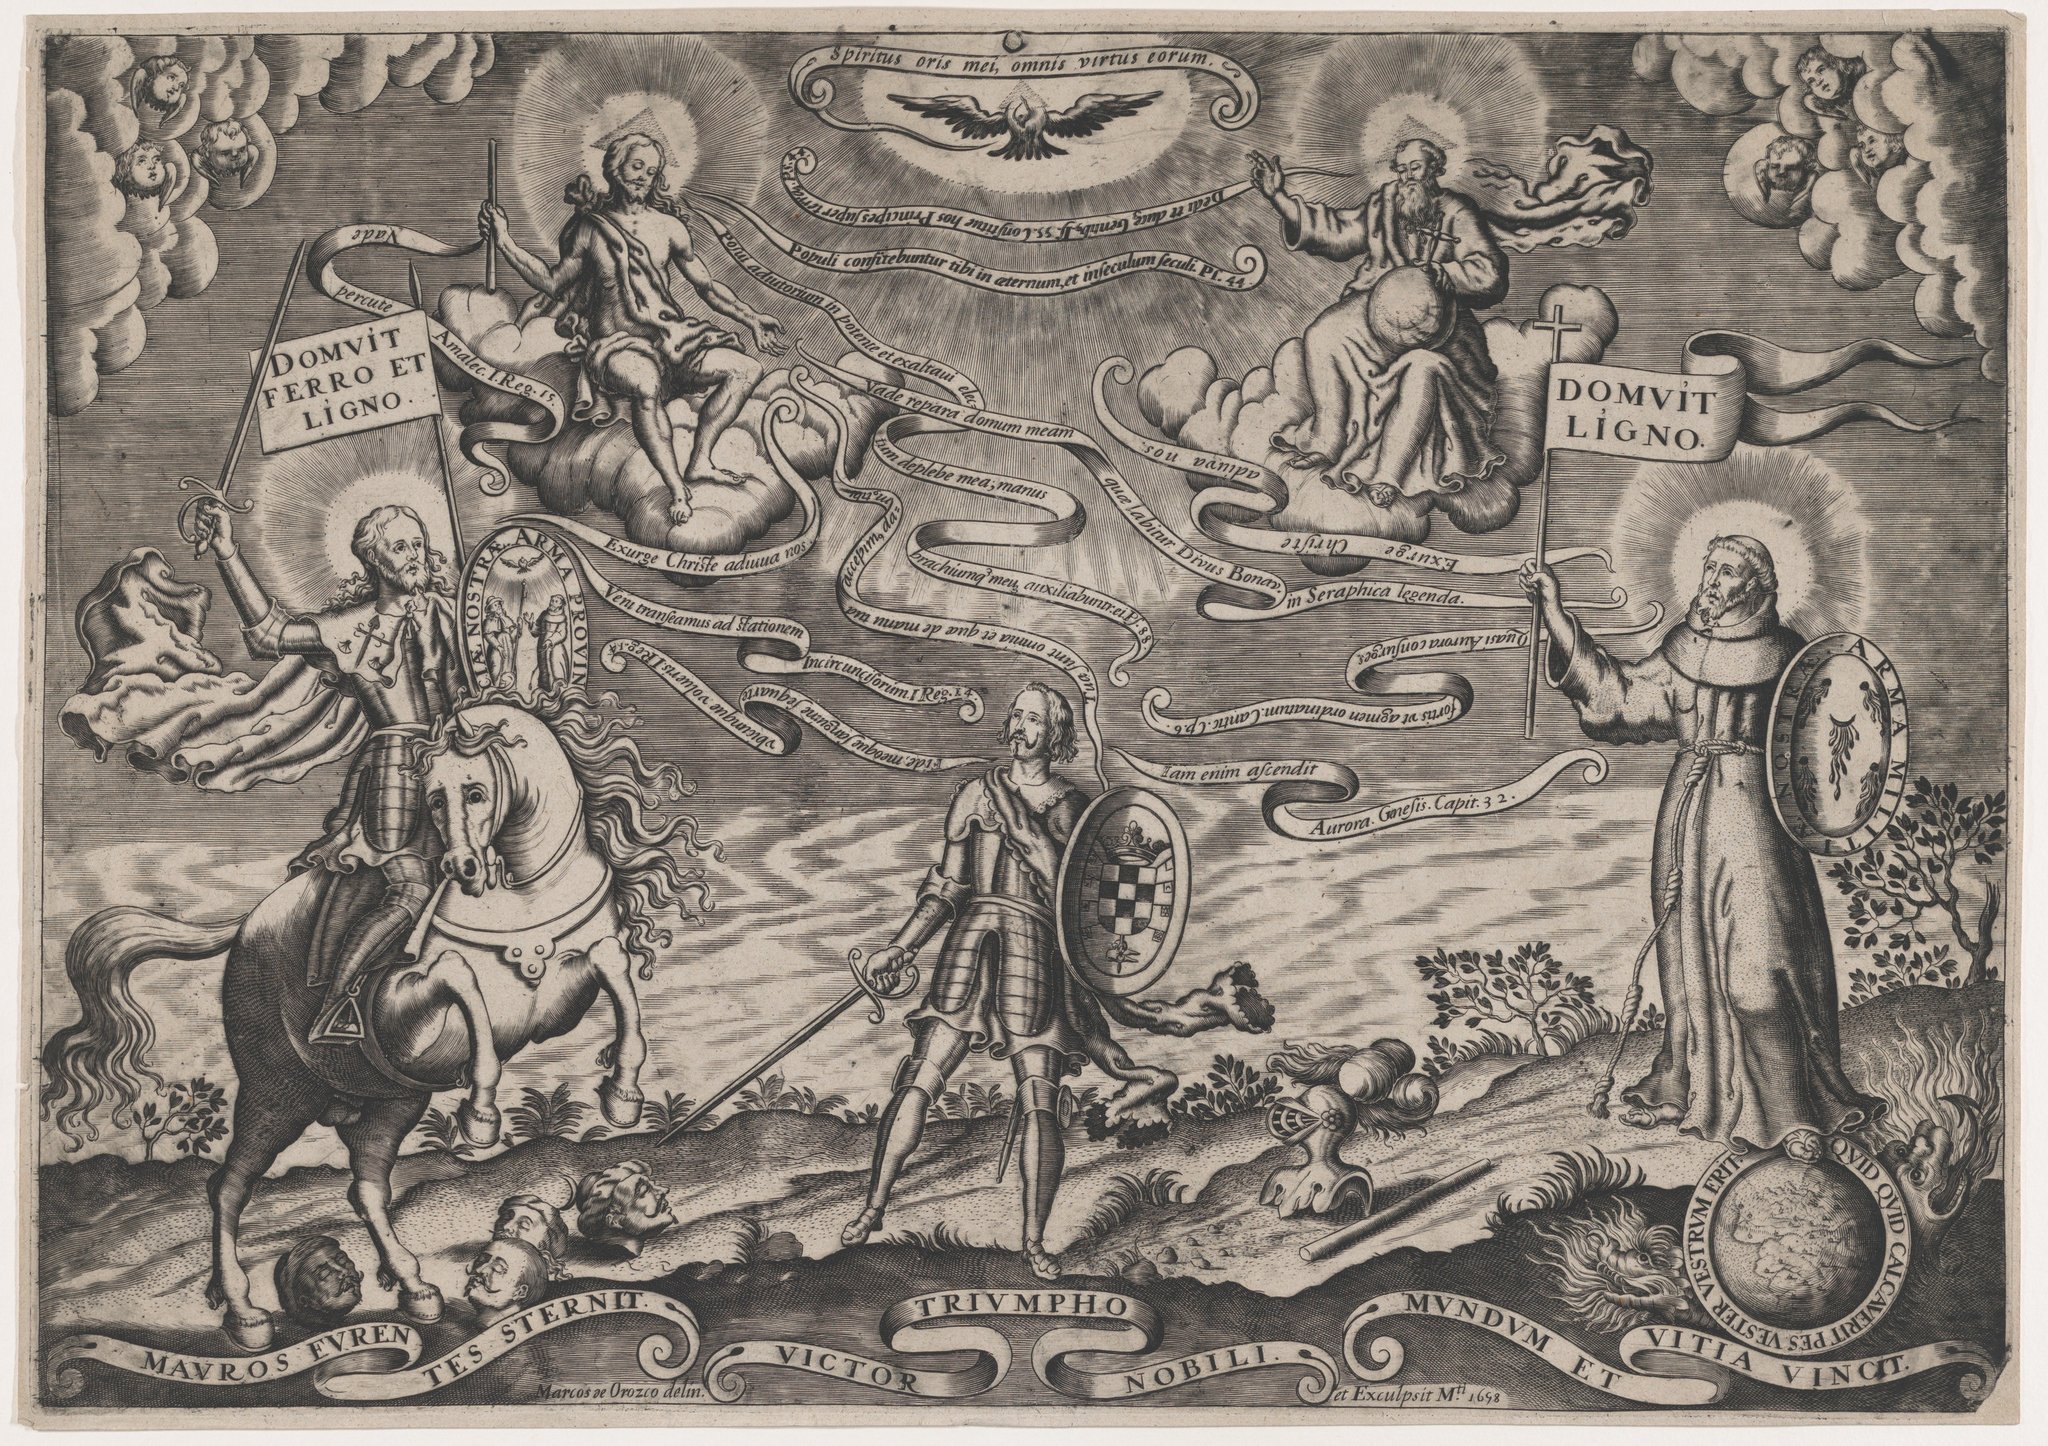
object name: print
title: The triumph of faith, a soldier standing in centre holding shield adorned with arms of Alva; Holy Trinity above, St James Major on horseback at left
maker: marcos de orozco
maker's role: artist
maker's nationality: spanish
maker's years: 1654-1707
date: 1698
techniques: engraving